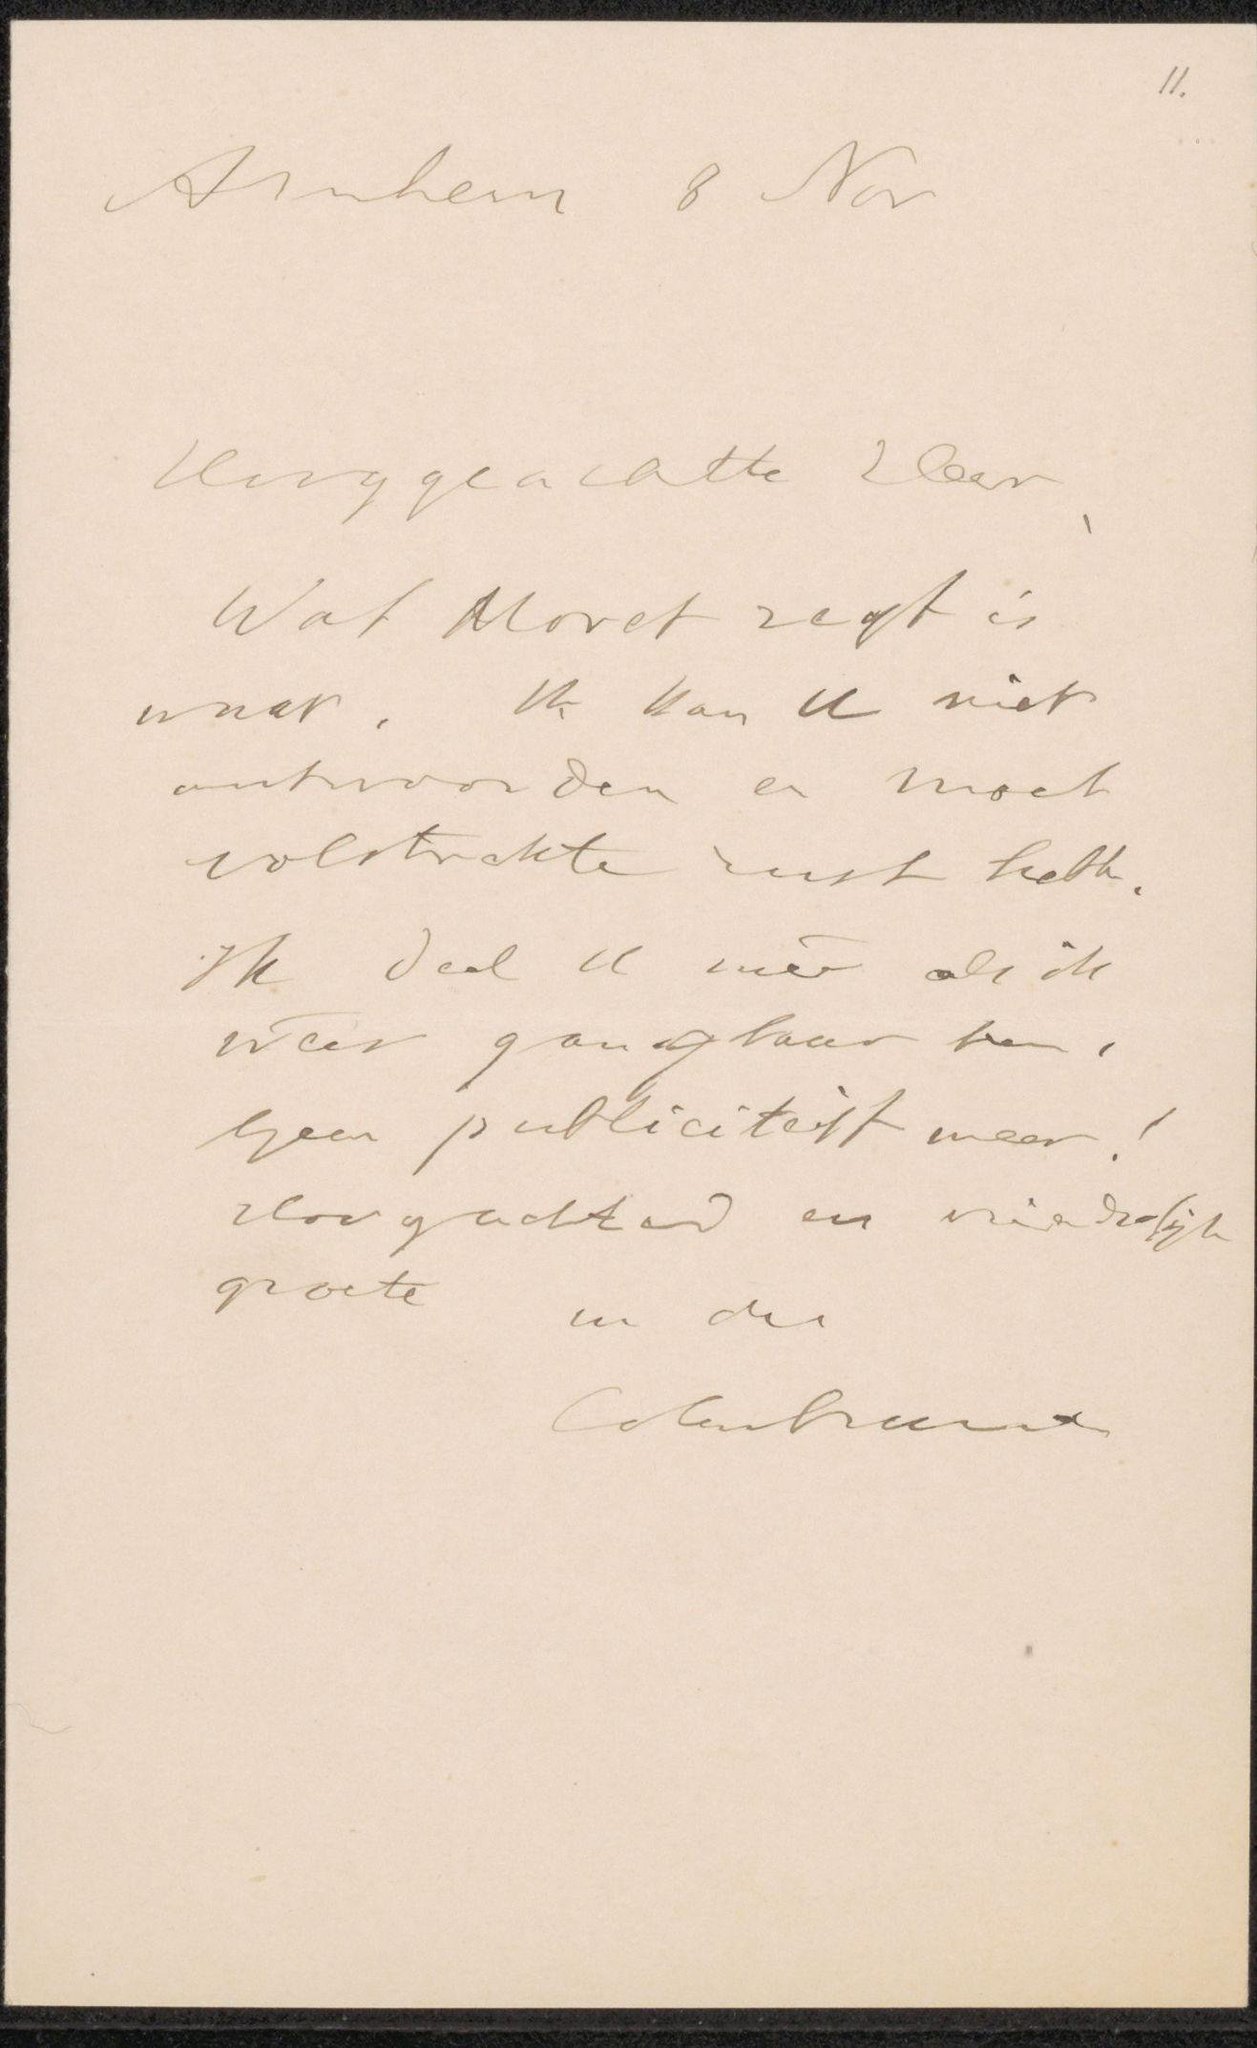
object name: letter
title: Brief aan Pieter Haverkorn van Rijsewijk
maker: theo colenbrander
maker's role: draughtsman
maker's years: 1841-1930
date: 1851-1915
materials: ink, paper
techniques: pen, writing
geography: arnhem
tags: pieter haverkorn van rijsewijk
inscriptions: collector's mark: ‘RPK’